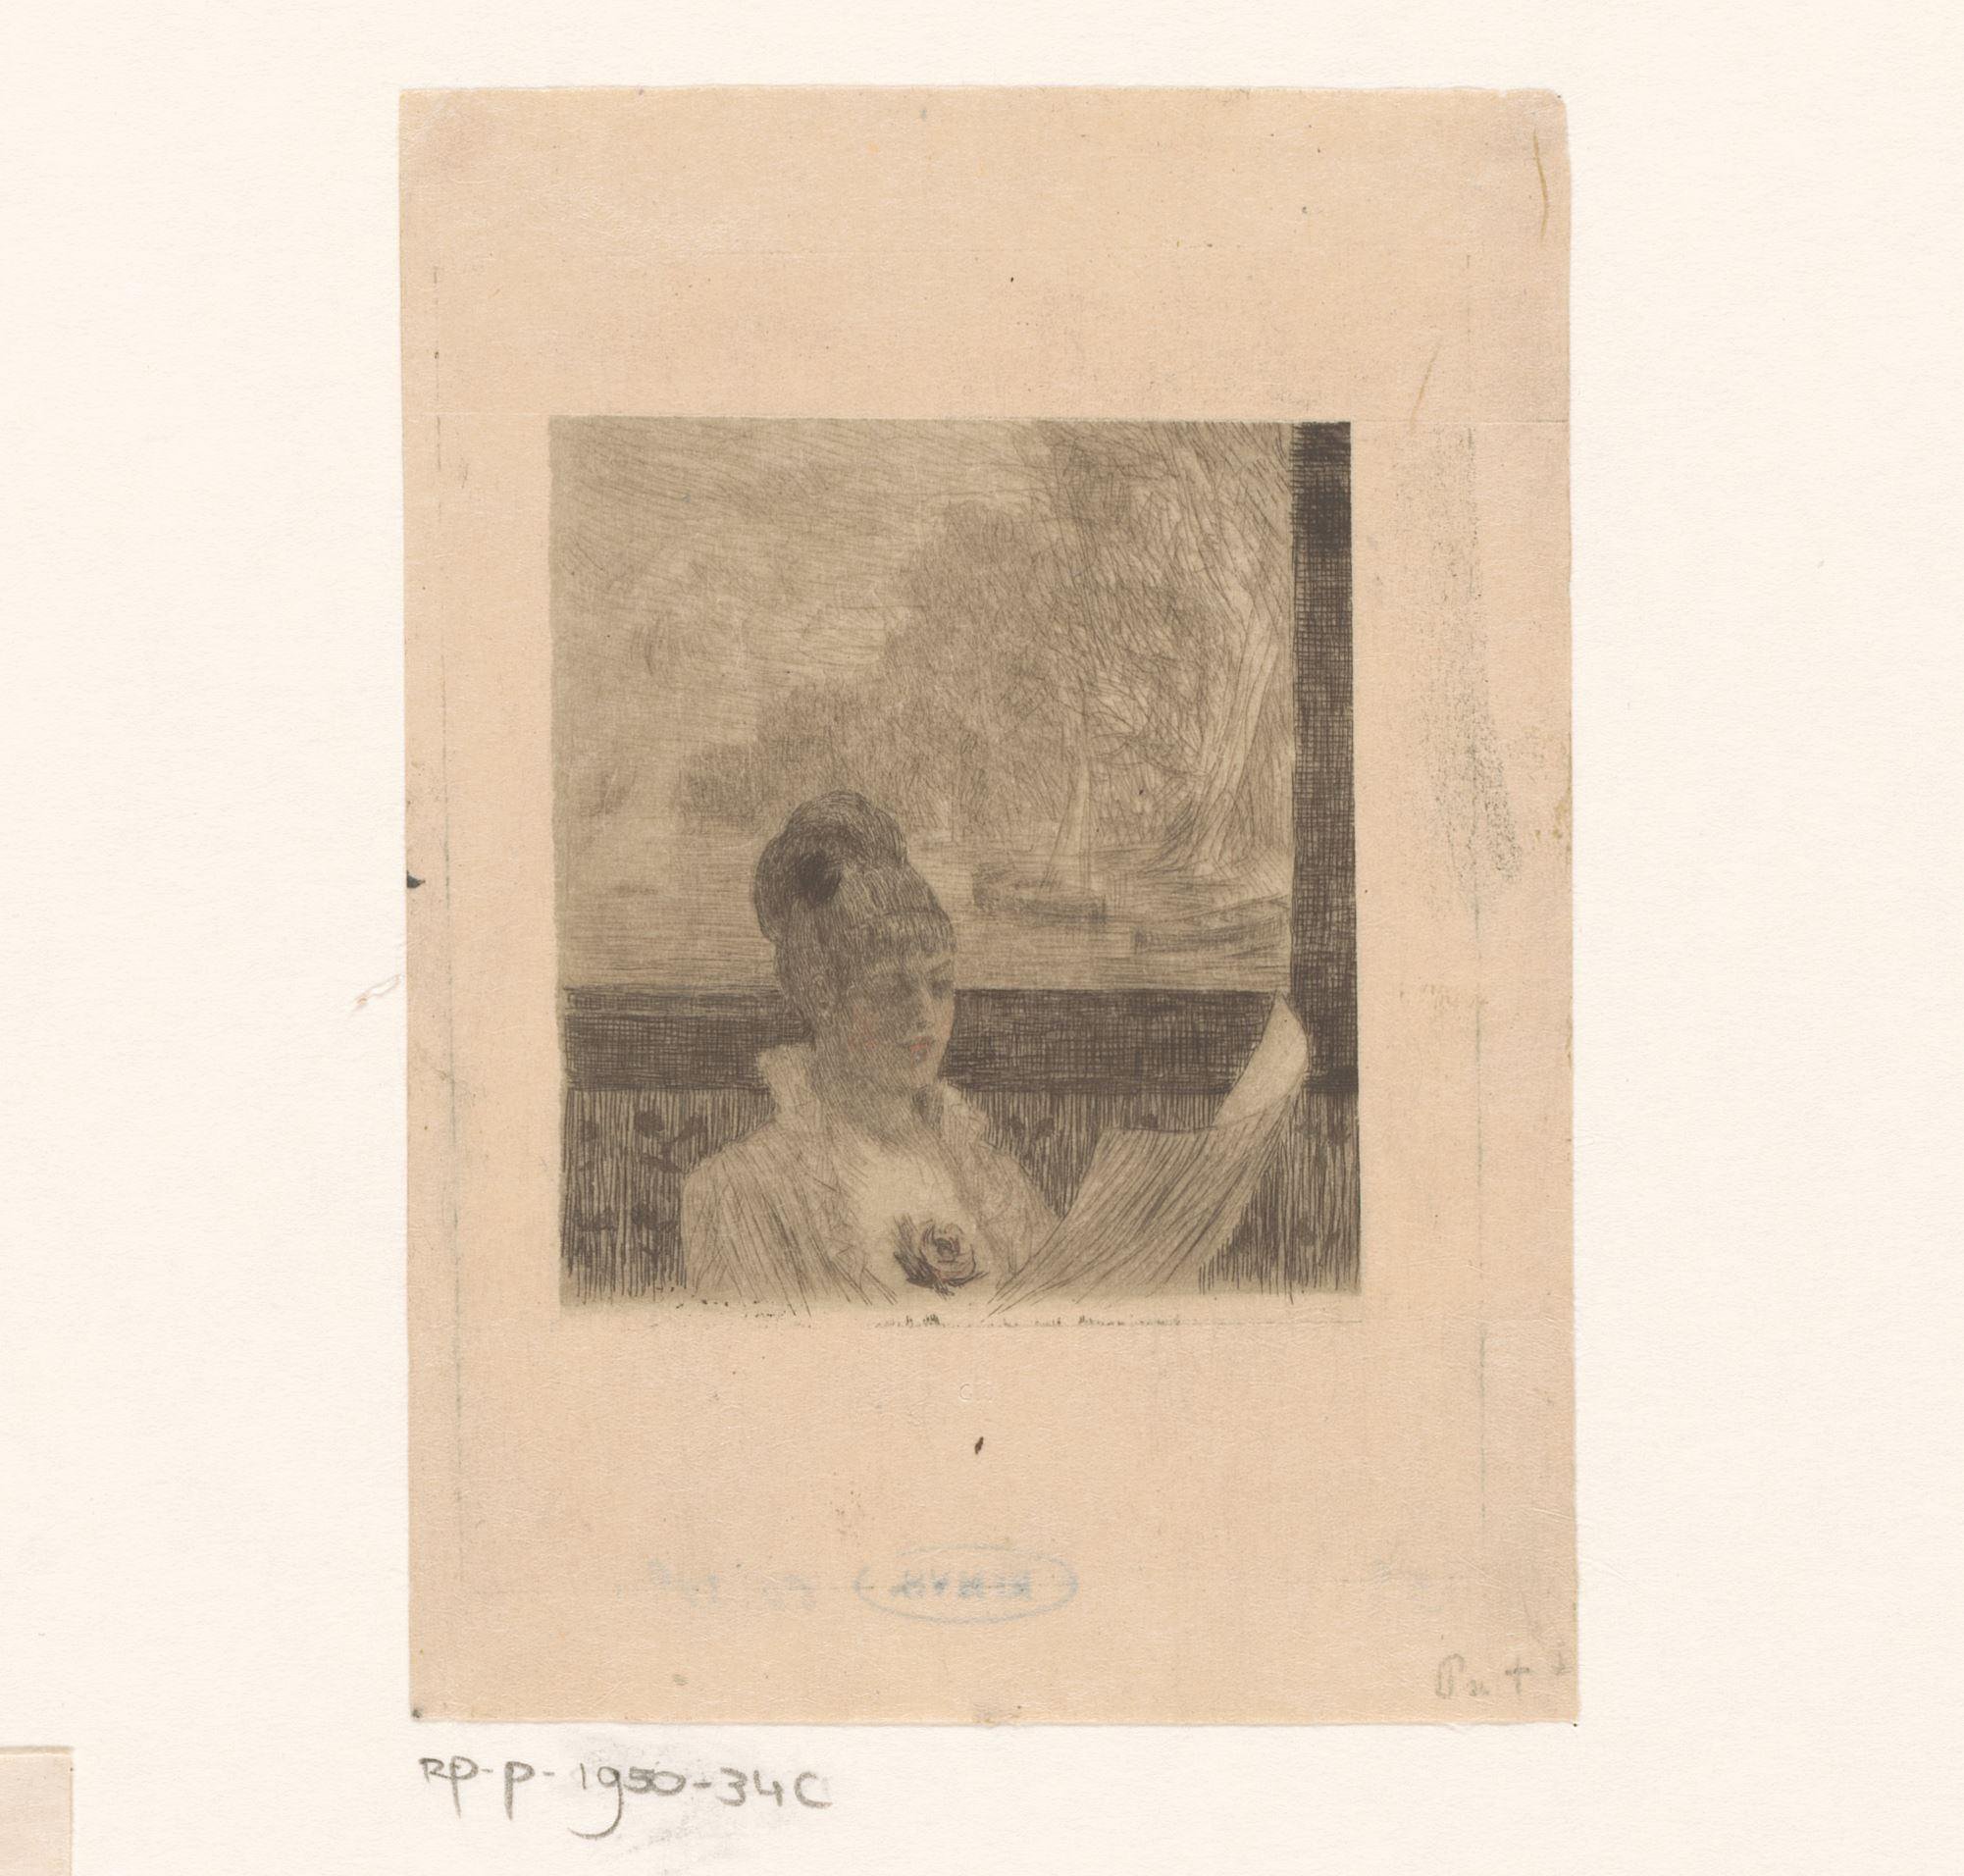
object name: print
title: Petite liseuse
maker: félicien rops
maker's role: draughtsman, print maker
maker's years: 1833-1898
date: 1879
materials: paper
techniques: drypoint, etching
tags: adult woman, reading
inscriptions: collector's mark: Lugt 2228, collector's mark: Lugt 601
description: Deze druk wordt in de literatuur niet specifiek beschreven. De randen van de plaat rechts en boven zijn strakker dan andere exemplaren, en tevens is de afbeelding een aantal millimeter smaller en lager. Waarschijnlijk is de plaat deels afgedekt geweest tijdens het drukken.